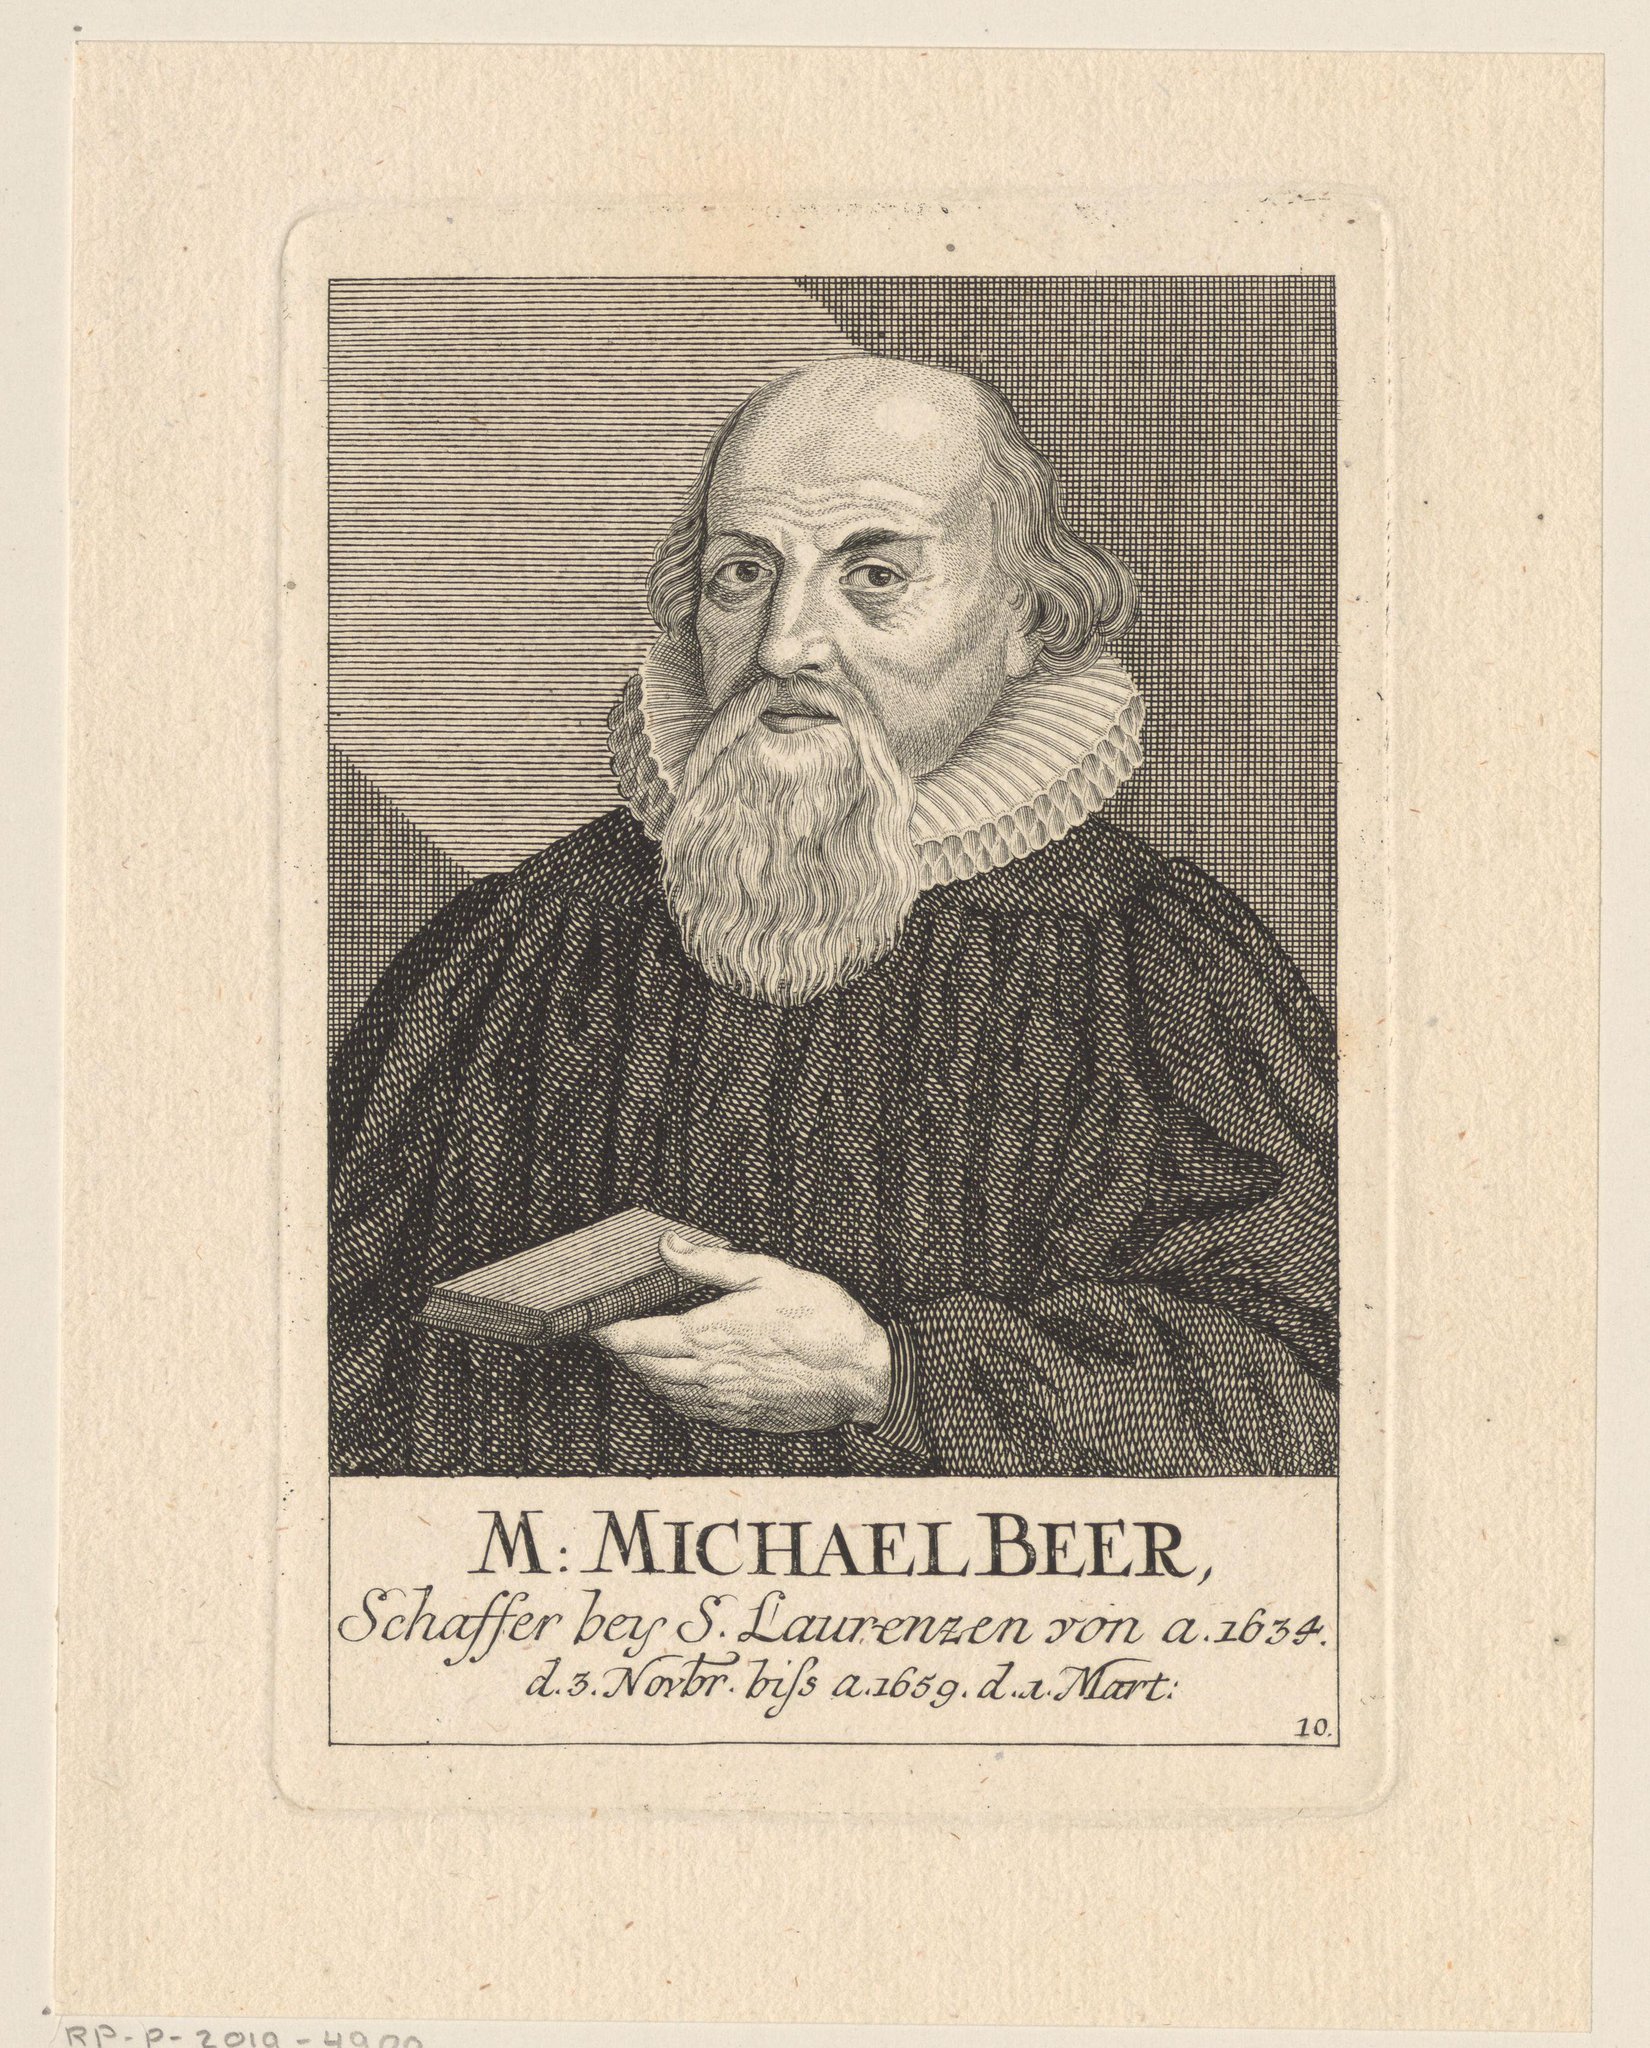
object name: print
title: Portret van Michael Beer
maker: christoph melchior roth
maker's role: print maker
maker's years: 1720-1798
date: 1756-1766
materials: paper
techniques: engraving, etching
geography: nuremberg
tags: theologian, historical persons, book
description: Prent uit: Würfel, Andreas. Lebensbeschreibung aller Herren Geistlichen, welche in der Reichs-Stadt Nürnberg und auf deren Land, seit der Reformation Lutheri gedienet, (...). 9 dln. Neurenberg: Christoph Melchior Roth, 1756-1766.